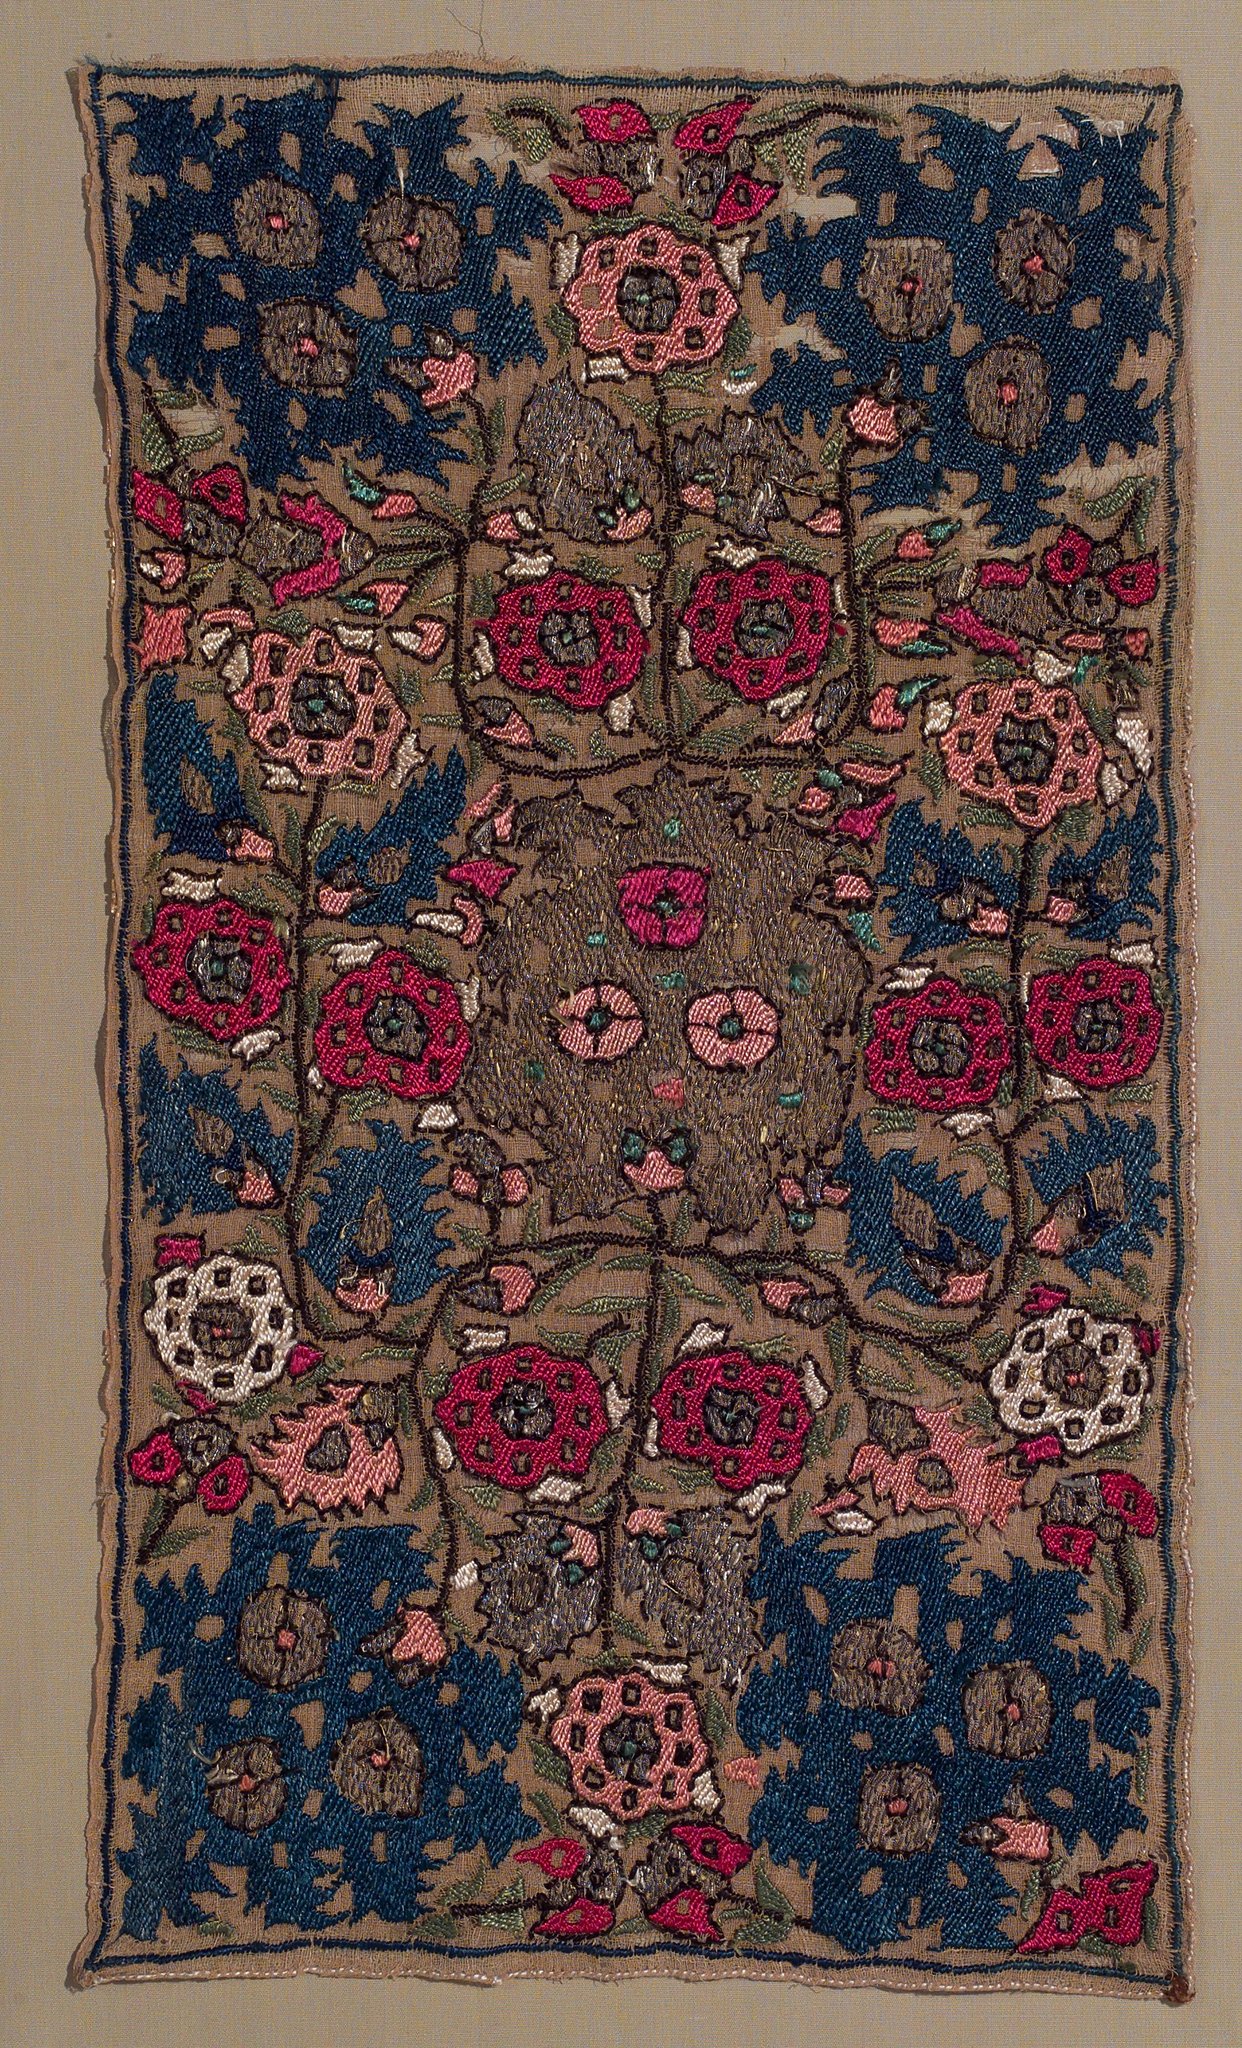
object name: panel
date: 1701-1800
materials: linen, metal thread, silk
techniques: embroidery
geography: algeria